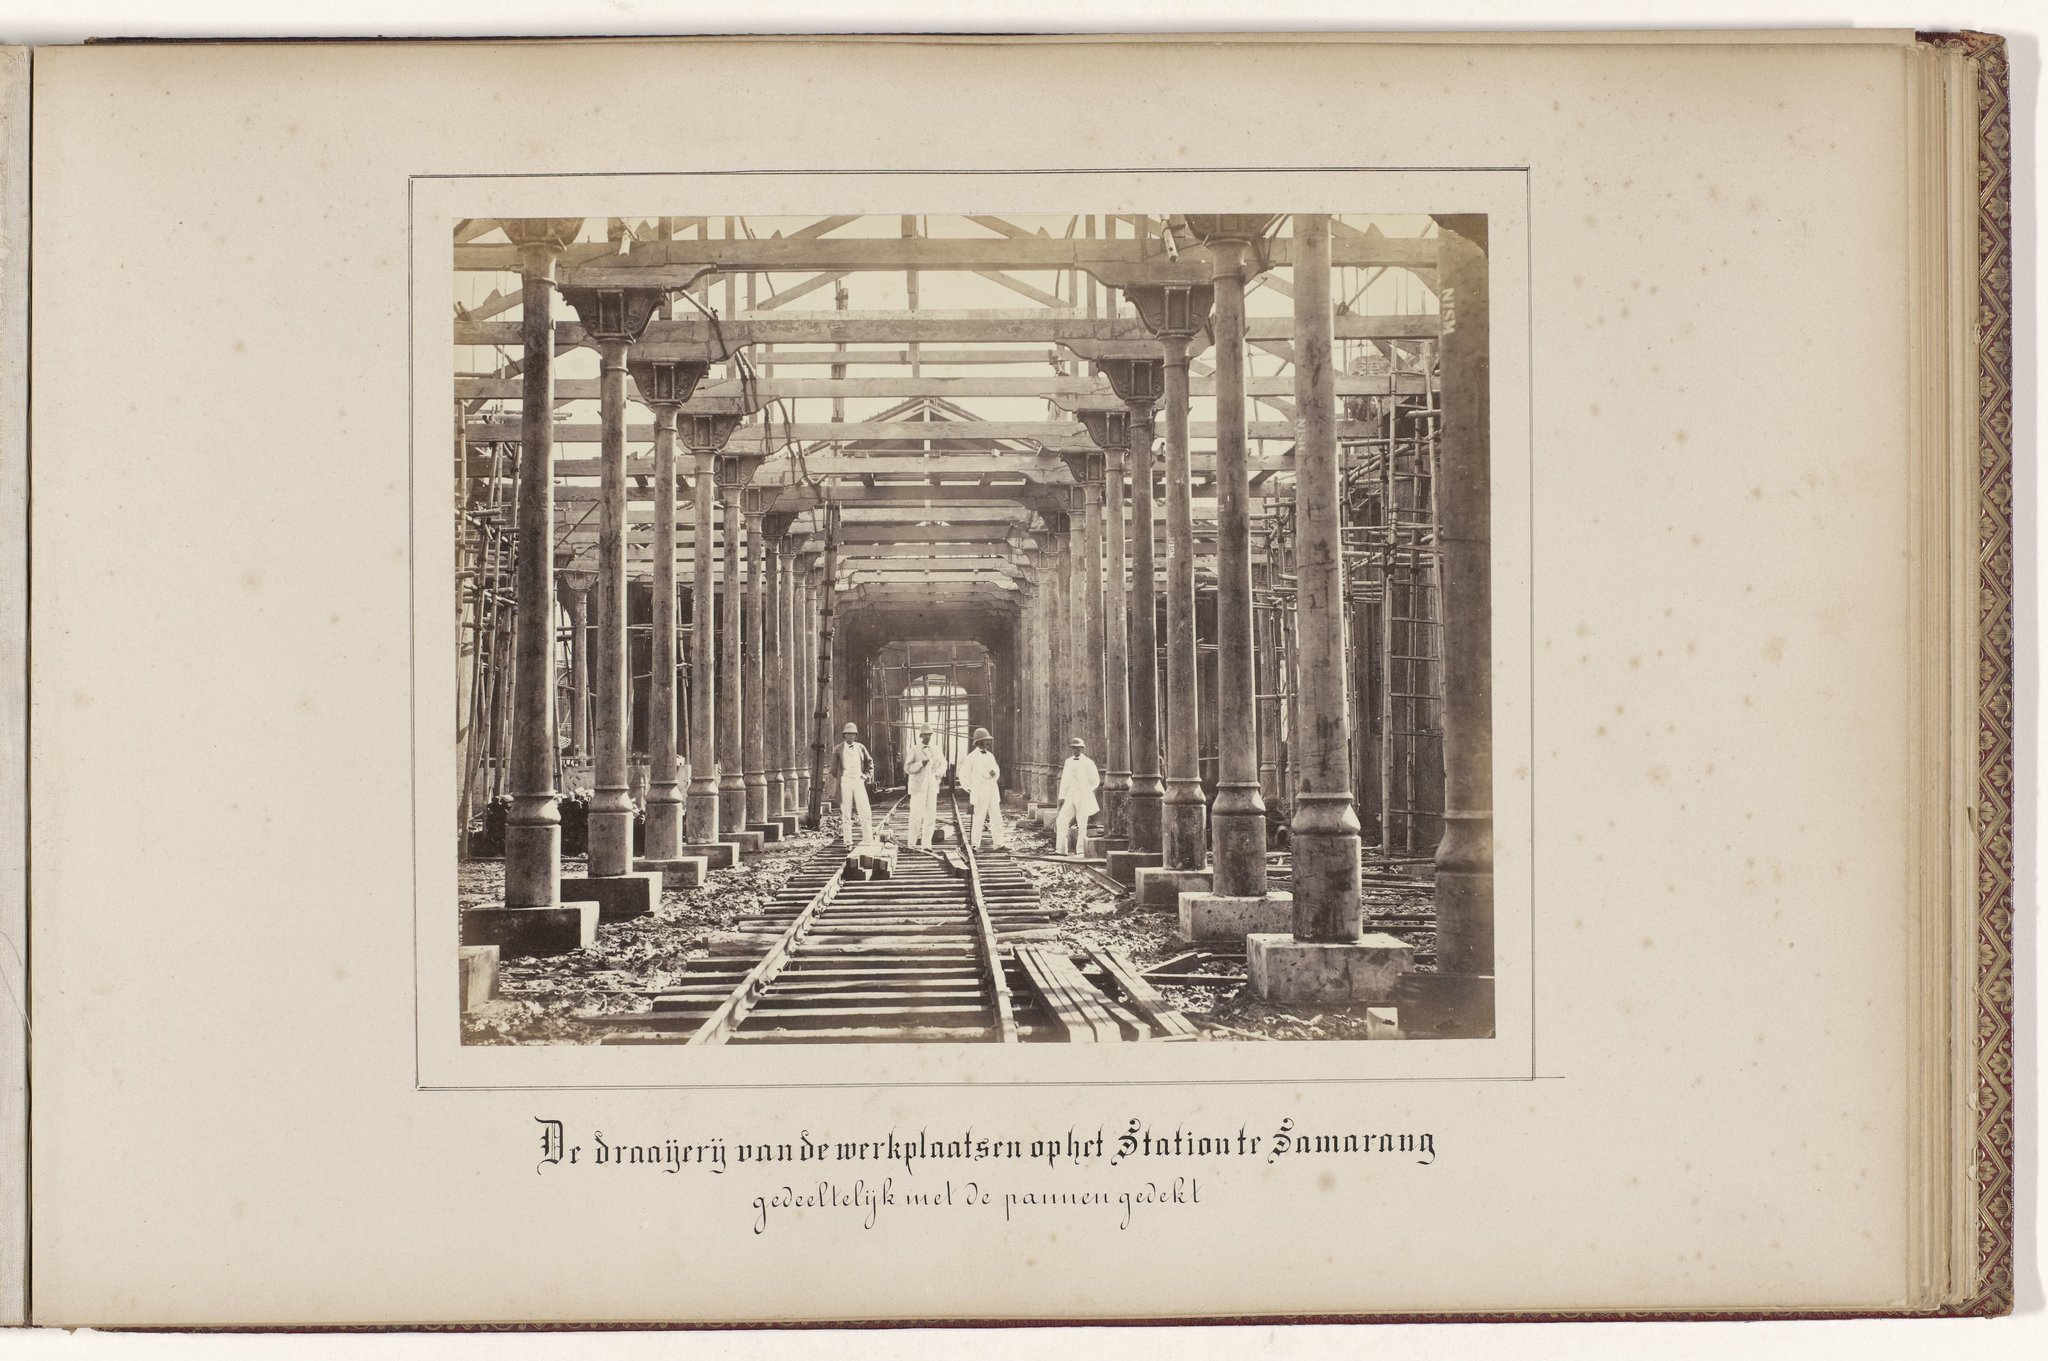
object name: album leaf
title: De draaijerij van de werkplaatsen op het Station te Samarang / gedeeltelijk met de pannen gedekt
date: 1865-1867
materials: cardboard, photographic support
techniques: albumen print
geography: java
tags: colonial system, railway-traffic, making the overground structures (~ building activities), interior of industrial structures (regardless of the materials processed or the products made, station; shelter (railway, tramway), java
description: Gezicht in het interieur van de draaierij in aanbouw op de werkplaats bij het treinstation van Semarang. Met vier Europese mannen staande op het spoor. Albumblad met opgeplakte foto, onderdeel van het fotoalbum over de aanleg van de spoorlijn Semarang - Kedoeng Djattie (Kedungjati) op Java in 1865.